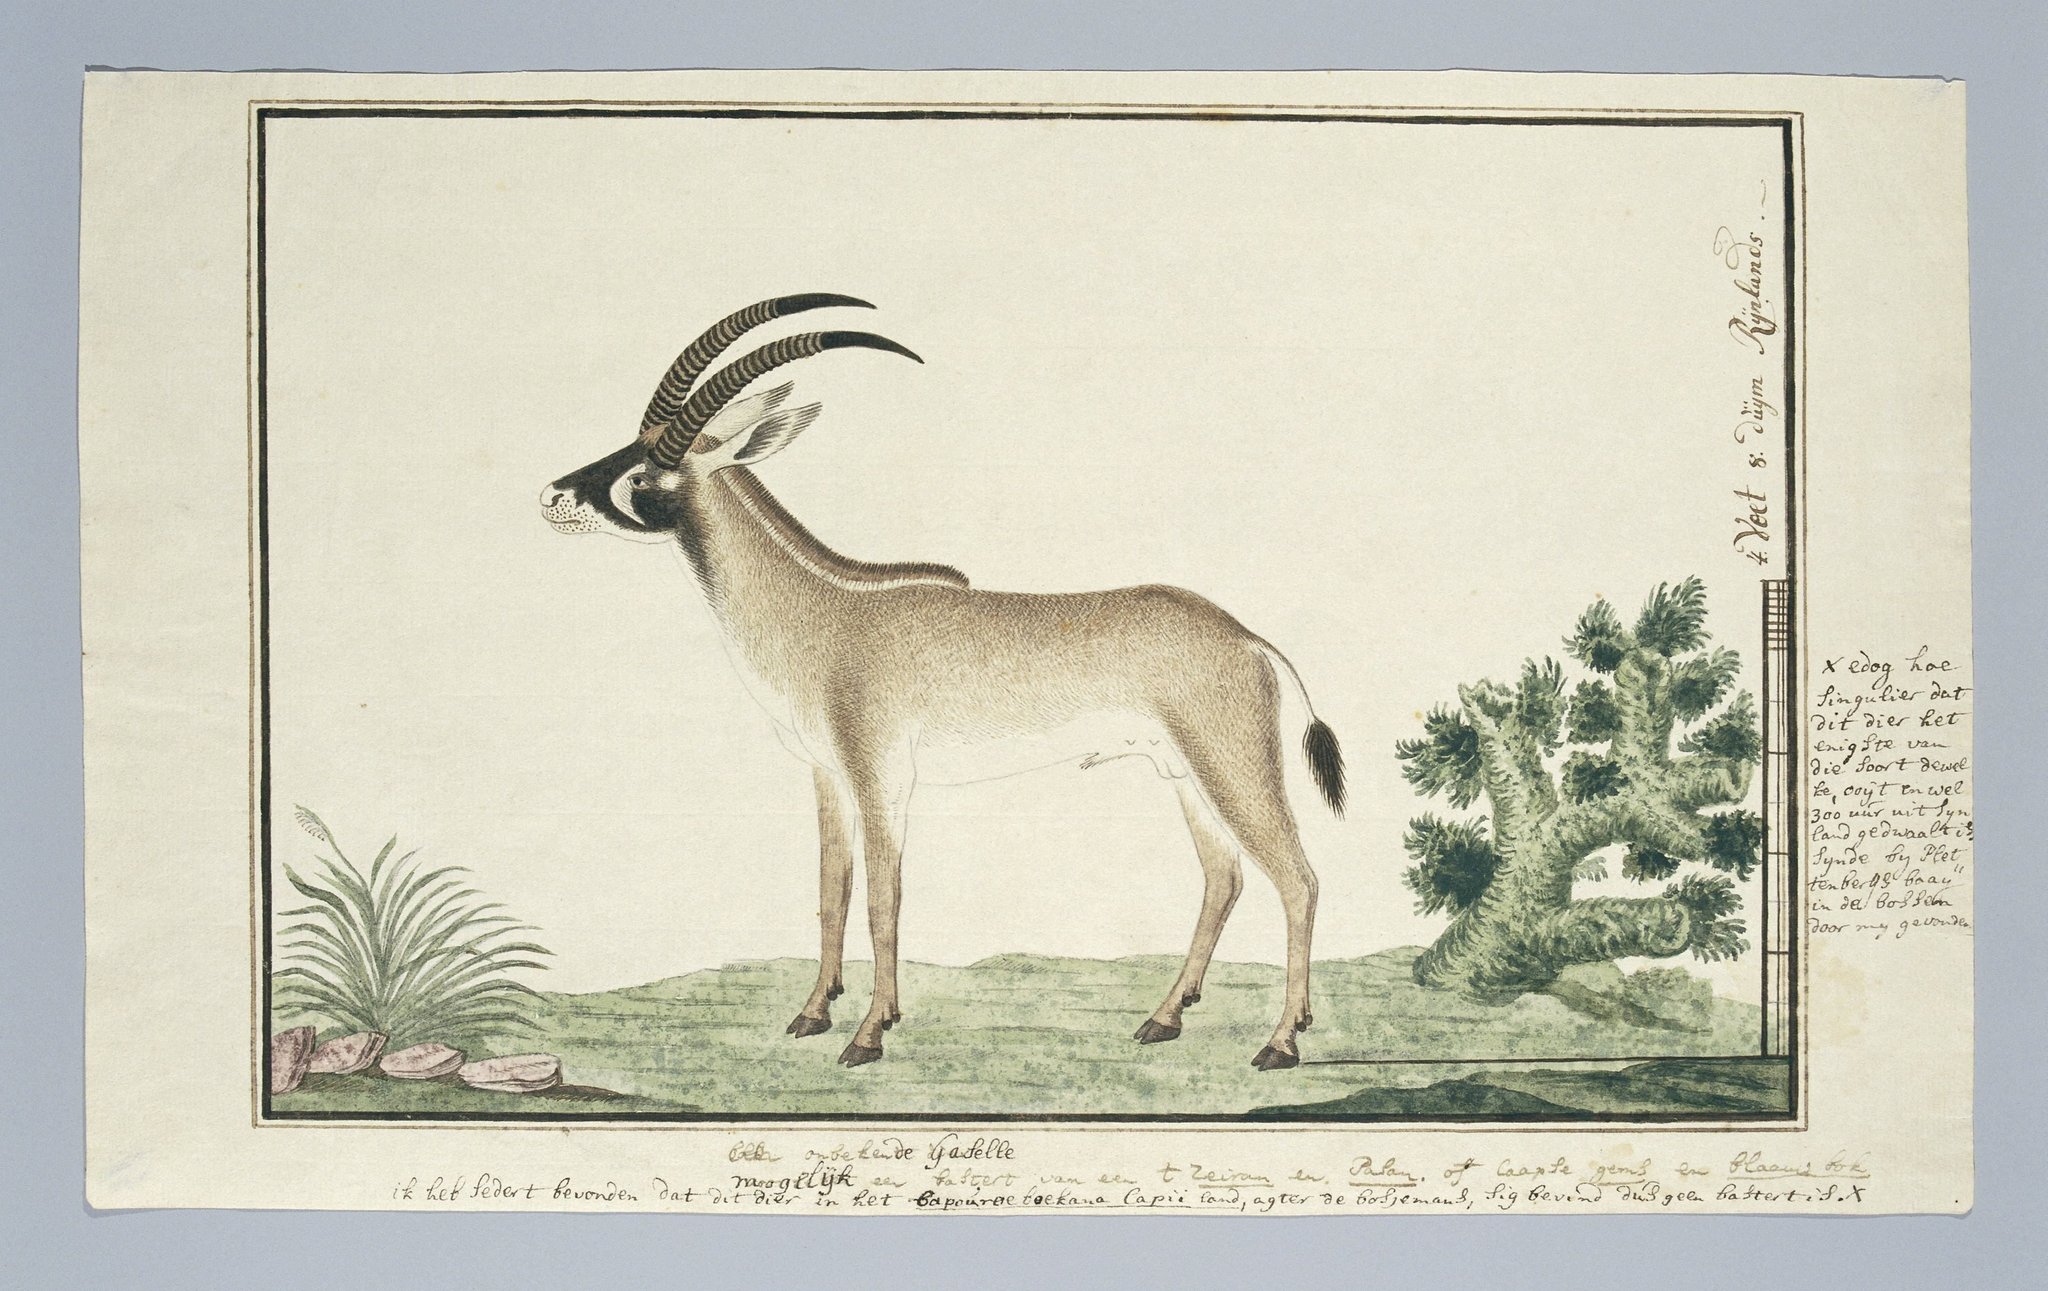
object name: album leaf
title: Hippotragus equinus (Roan antelope)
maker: robert jacob gordon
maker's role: draughtsman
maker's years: 1743-1795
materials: chalk, ink, paper, pencil, watercolor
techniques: brush, pen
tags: animals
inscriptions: annotation: ‘...onbekende gaselle...bij Plettenbergsbaaij in de bossen gevonden...; schaalverdeling rechtsonder: 4. Voet 8. duijm Rijnlands.~’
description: Bastergemsbok (Hippotragus equinus), kruising tussen een gemsbok en een bloubok; met schaalverdeling in Rijnlandse maat.